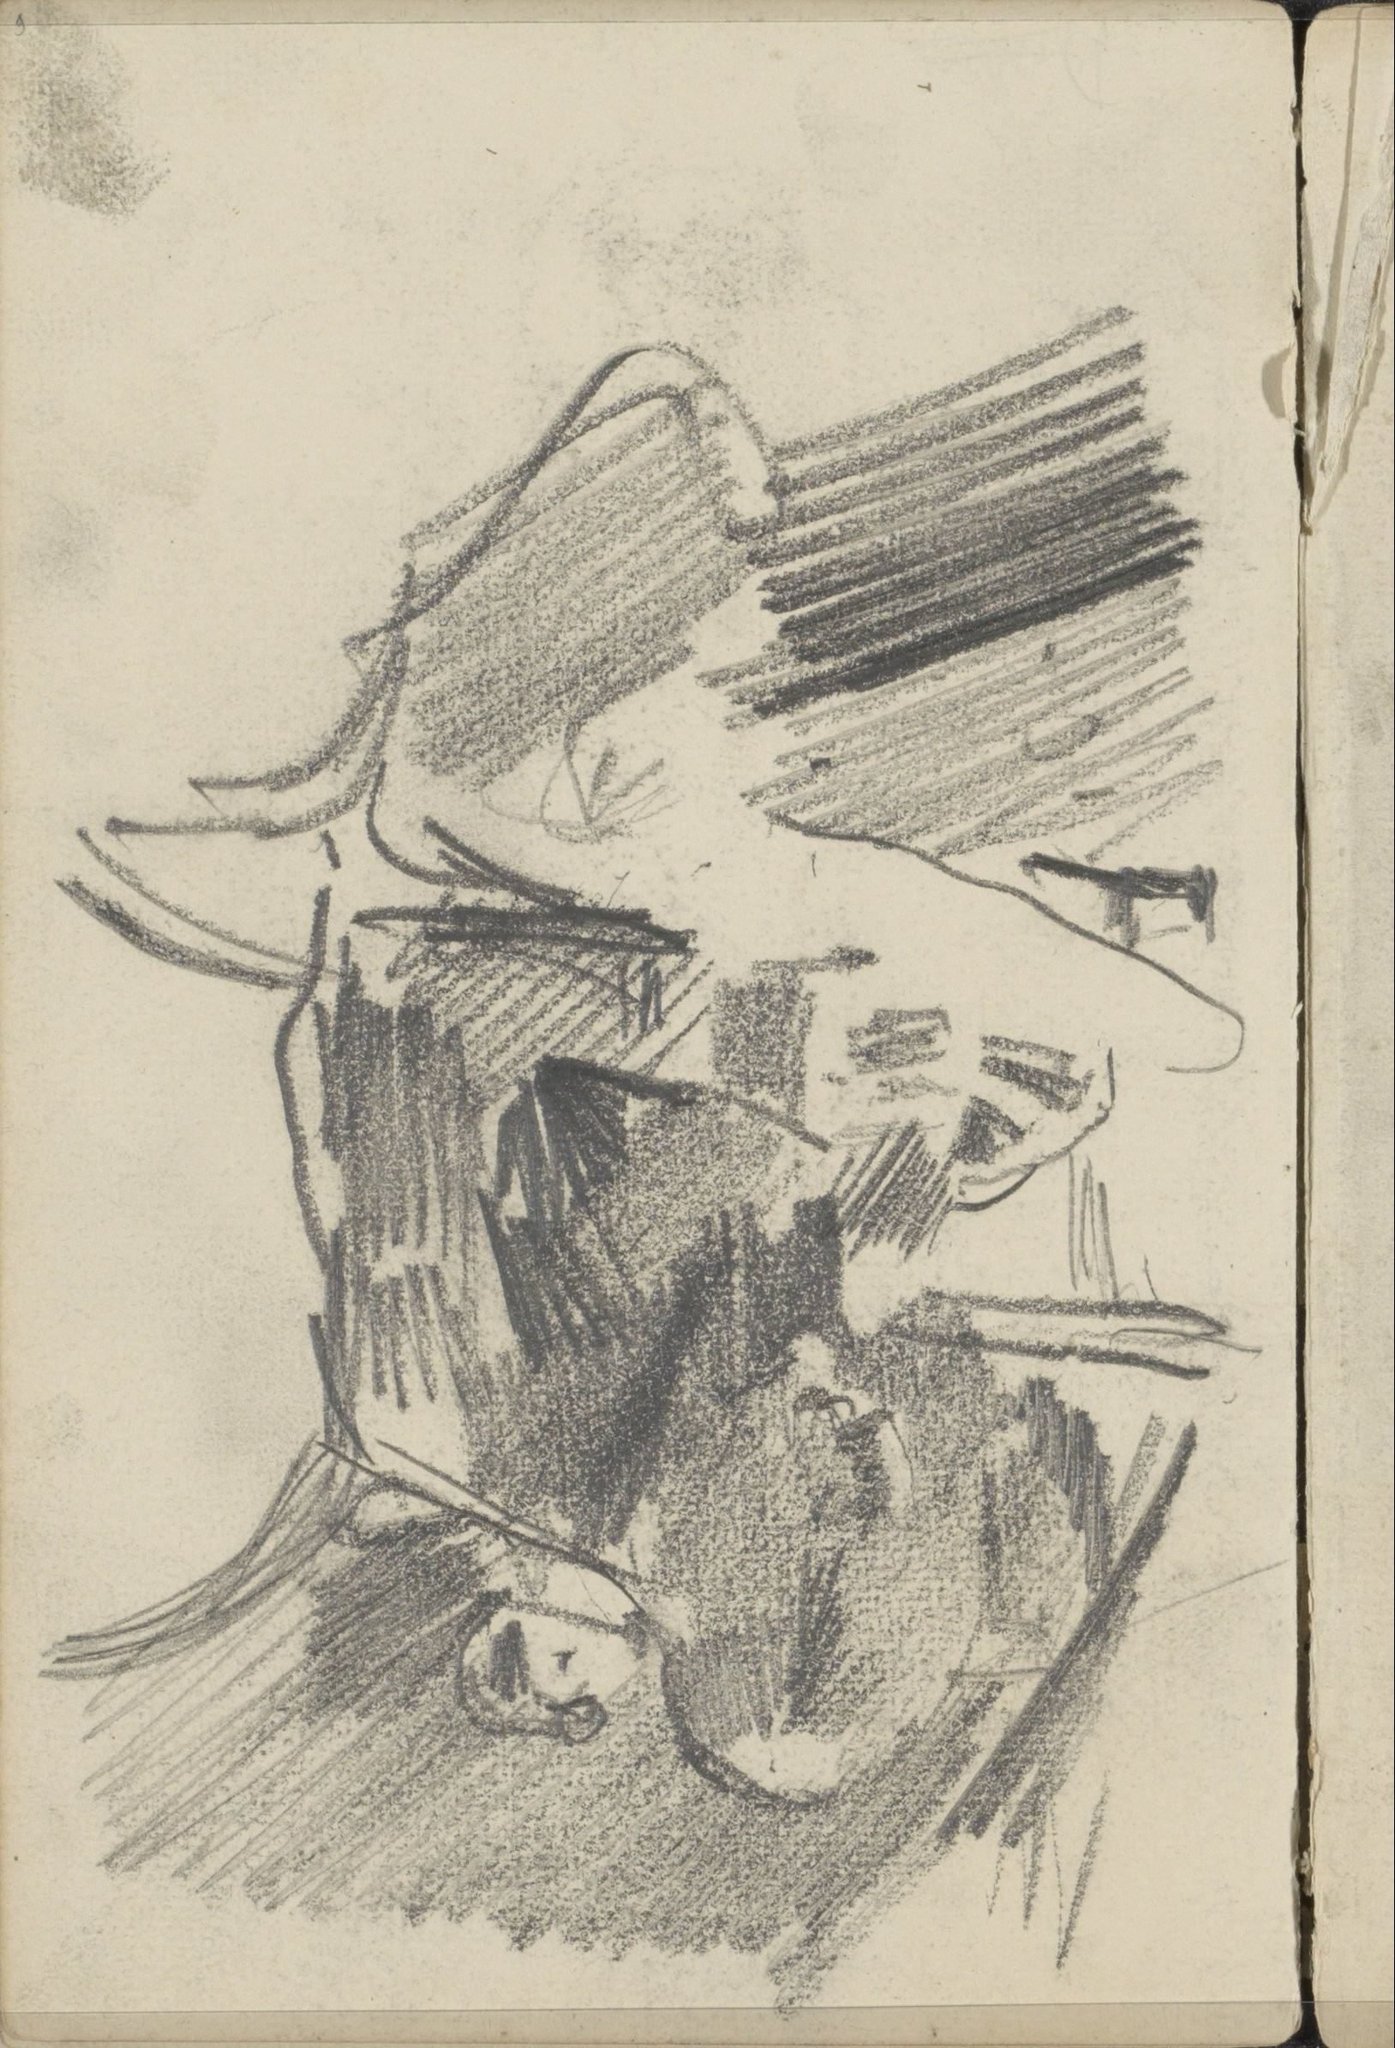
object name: sketchbook leaf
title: Man, mogelijk zittend aan een schrijftafel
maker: george hendrik breitner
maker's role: draughtsman, painter, print maker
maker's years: 1857-1923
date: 1887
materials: paper, pencil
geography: amsterdam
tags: writing-table, writing-desk, sitting on an elevation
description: Pagina 9 uit een schetsboek met 12 bladen.